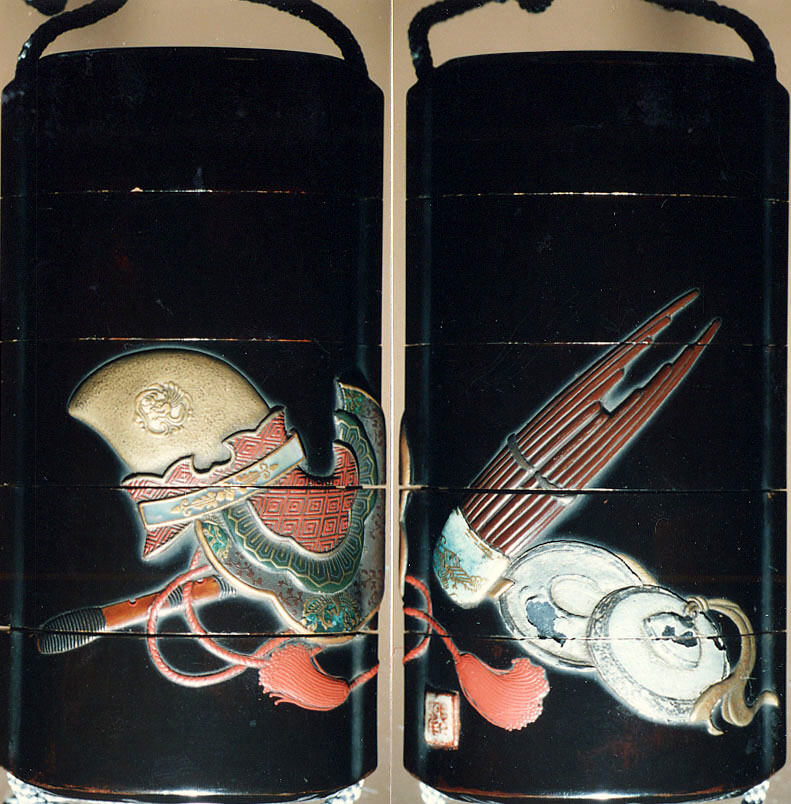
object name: inrō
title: Case (Inrō) with Design of Bugaku Hat (obverseI; Shō Flute and Cymbals (reverse)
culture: japanese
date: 1801-1900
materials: gold, lacquer, marble, mother of pearl, pewter, pottery, wood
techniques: fundame, inlay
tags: musical instruments